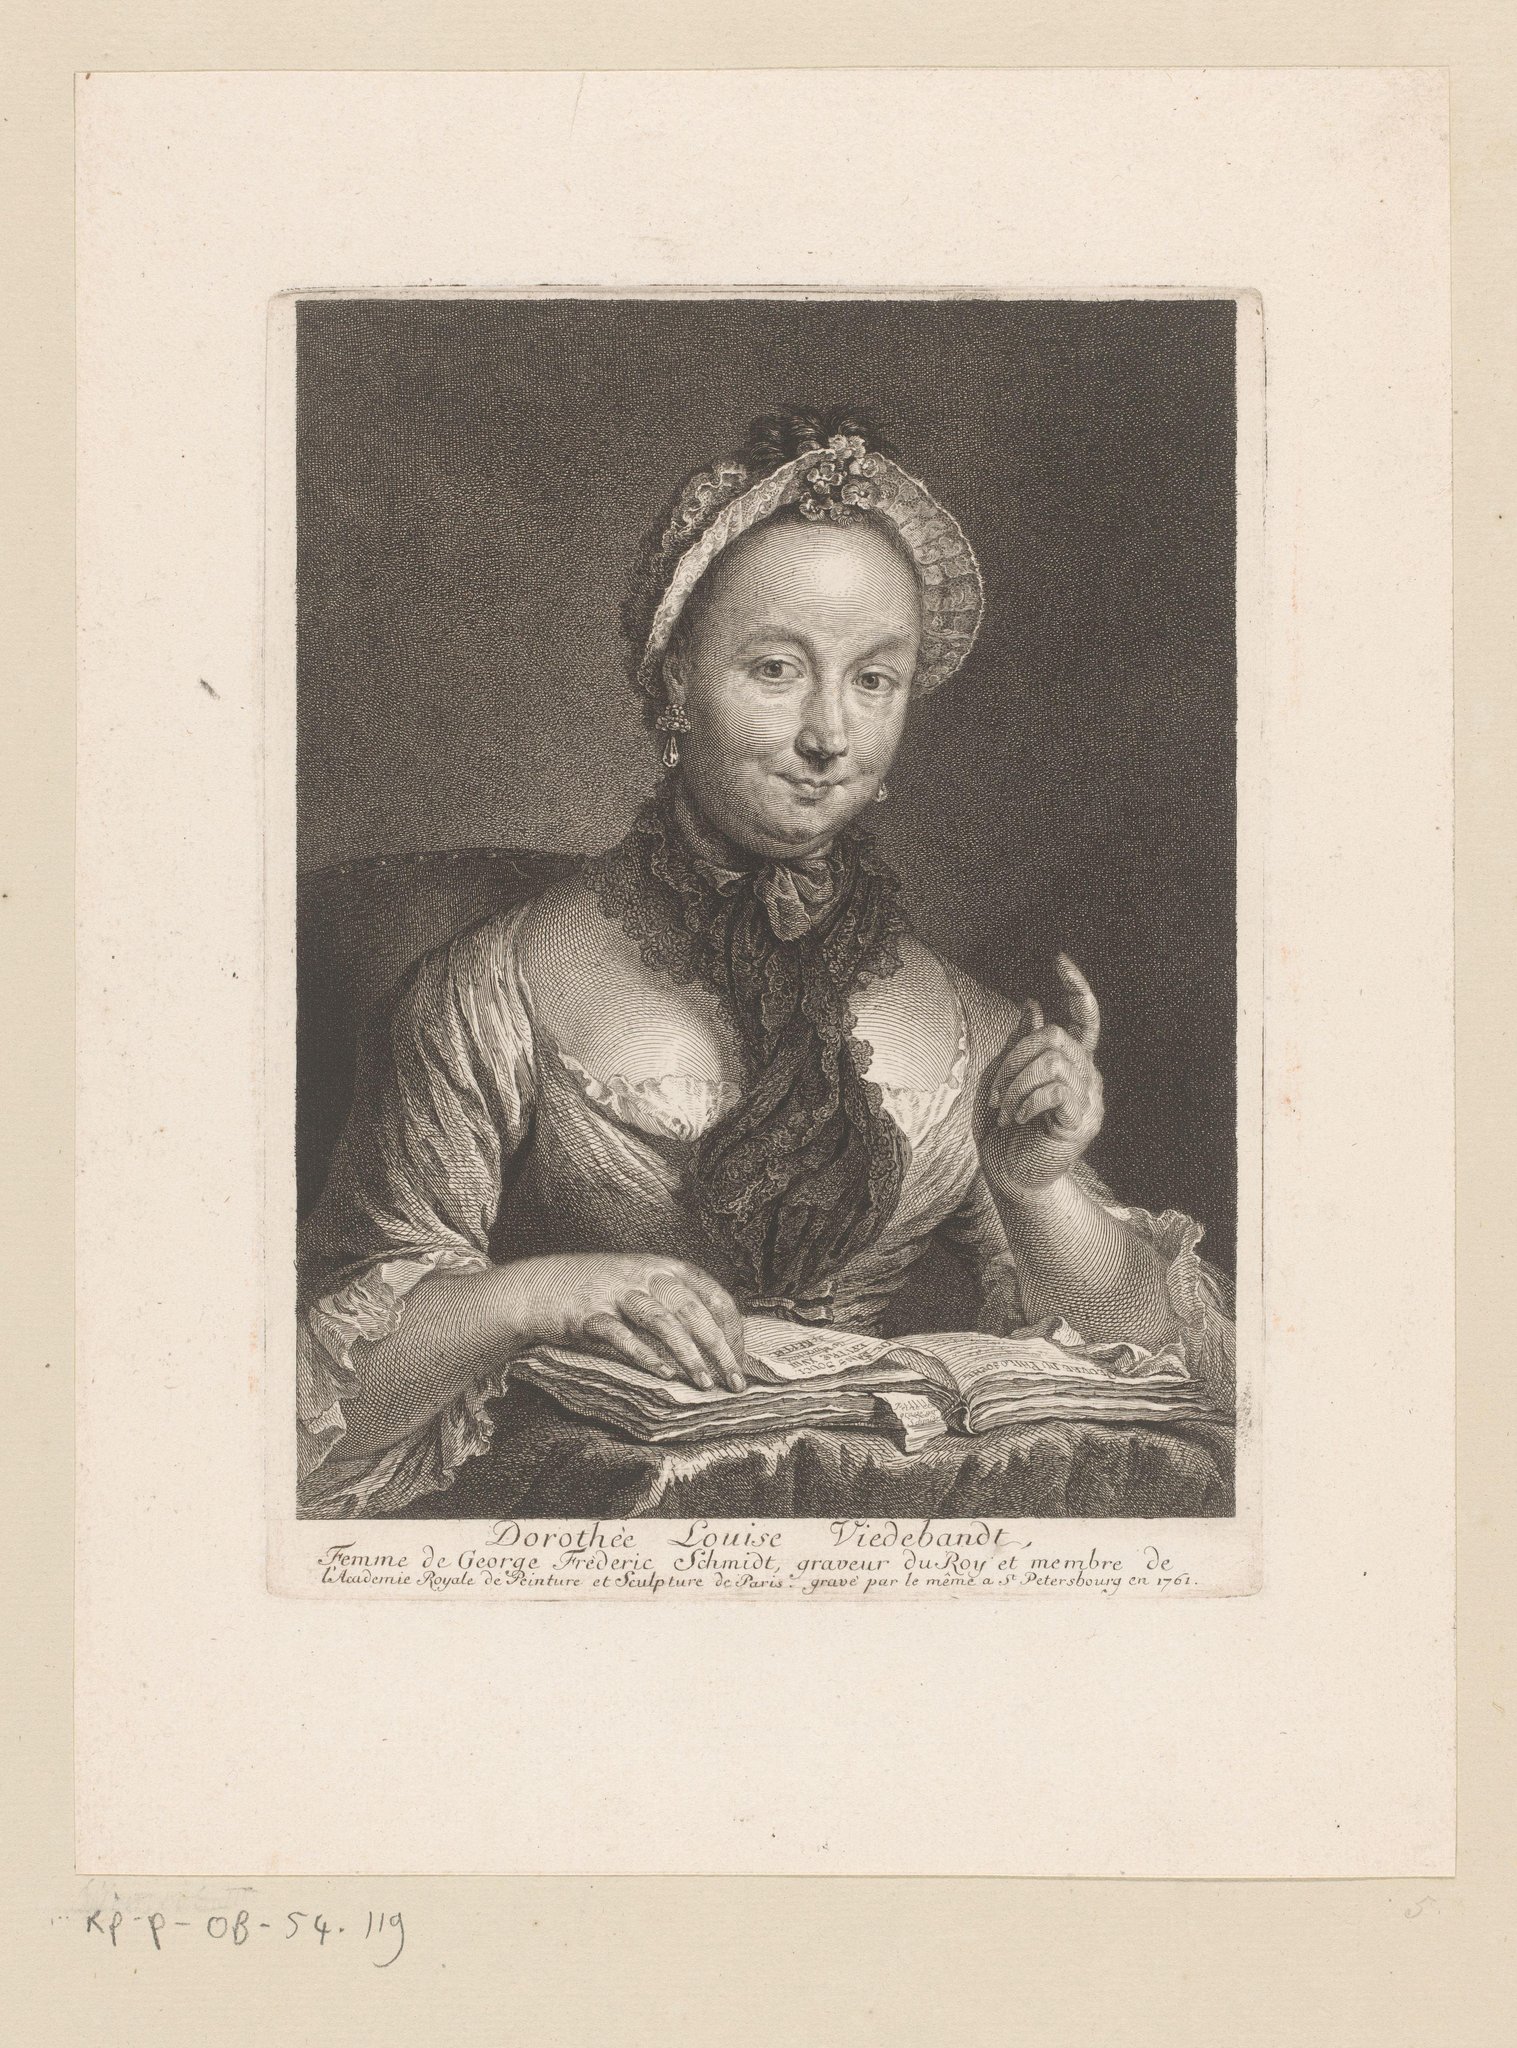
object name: print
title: Portret van Dorothea Louise Schmidt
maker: georg friedrich schmidt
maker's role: draughtsman, print maker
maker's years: 1712-1775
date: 1761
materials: paper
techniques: etching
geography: sint-petersburg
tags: historical persons - bb - woman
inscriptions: collector's mark: Lugt 240